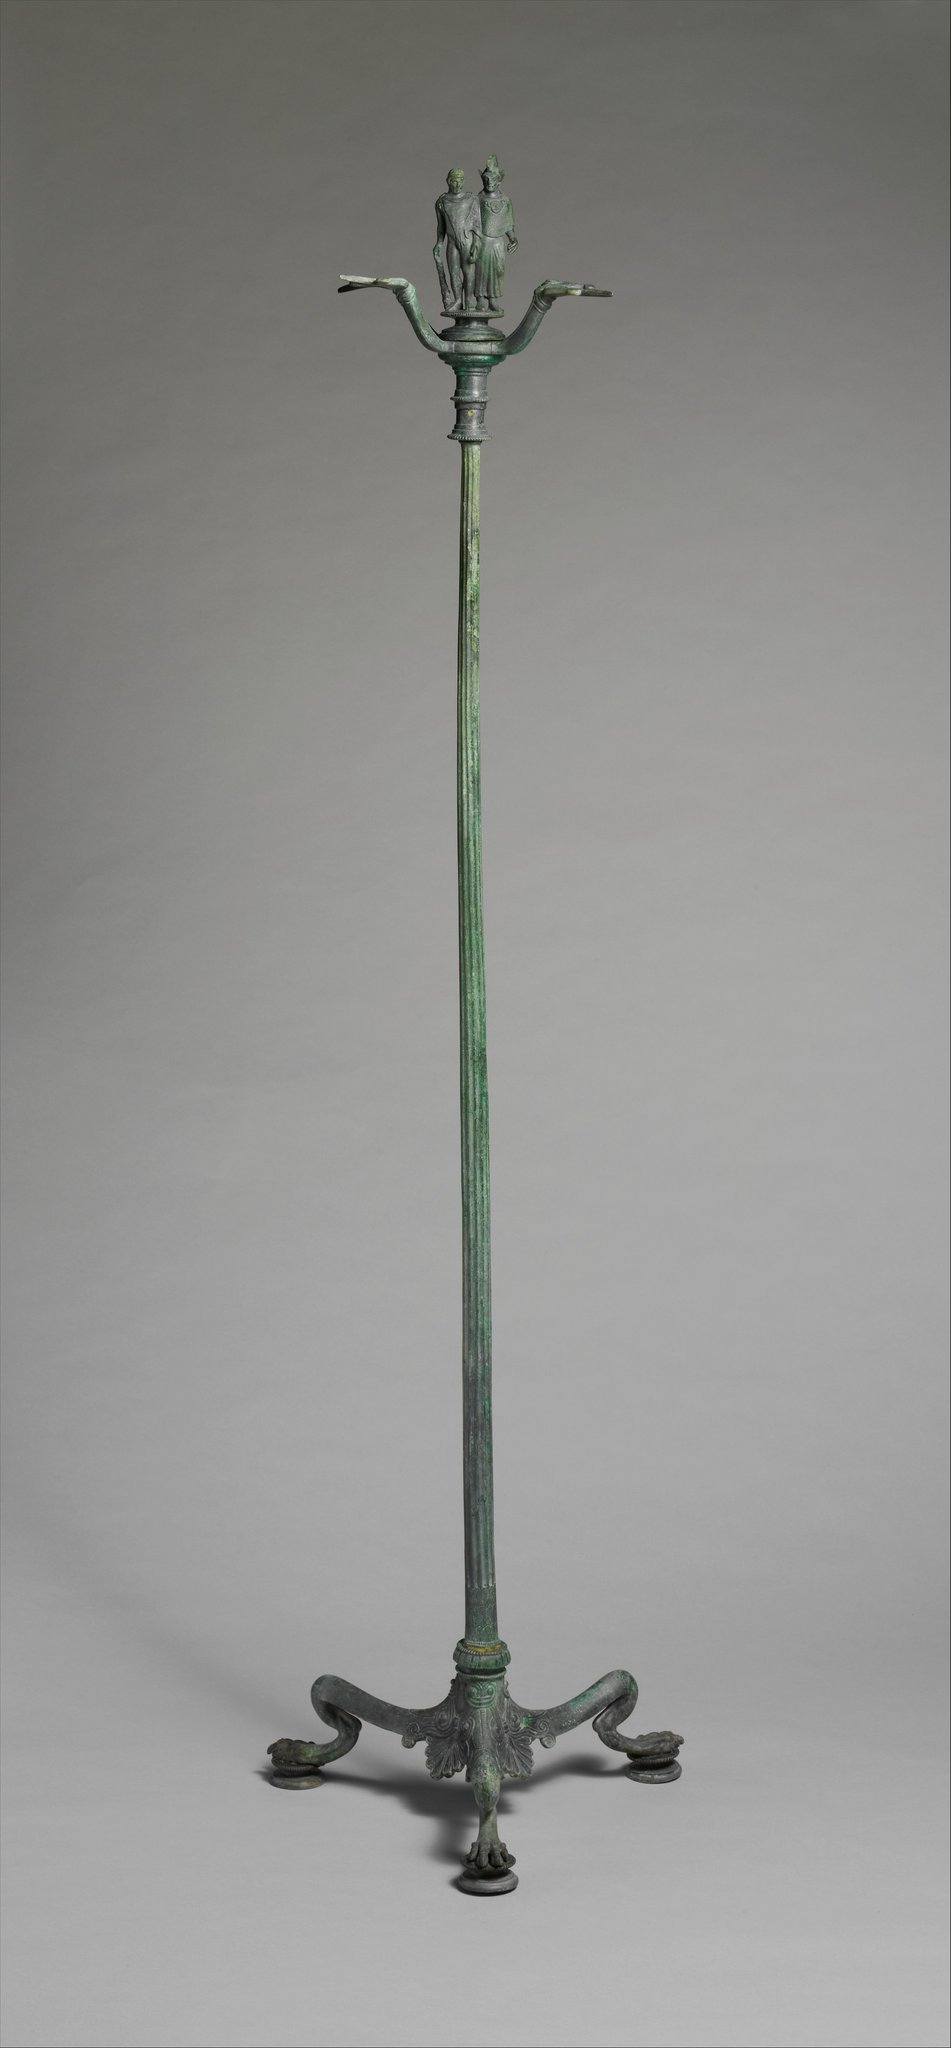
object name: thymiaterion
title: Bronze candelabrum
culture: etruscan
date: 500-475 BCE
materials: bronze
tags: athena,herakles